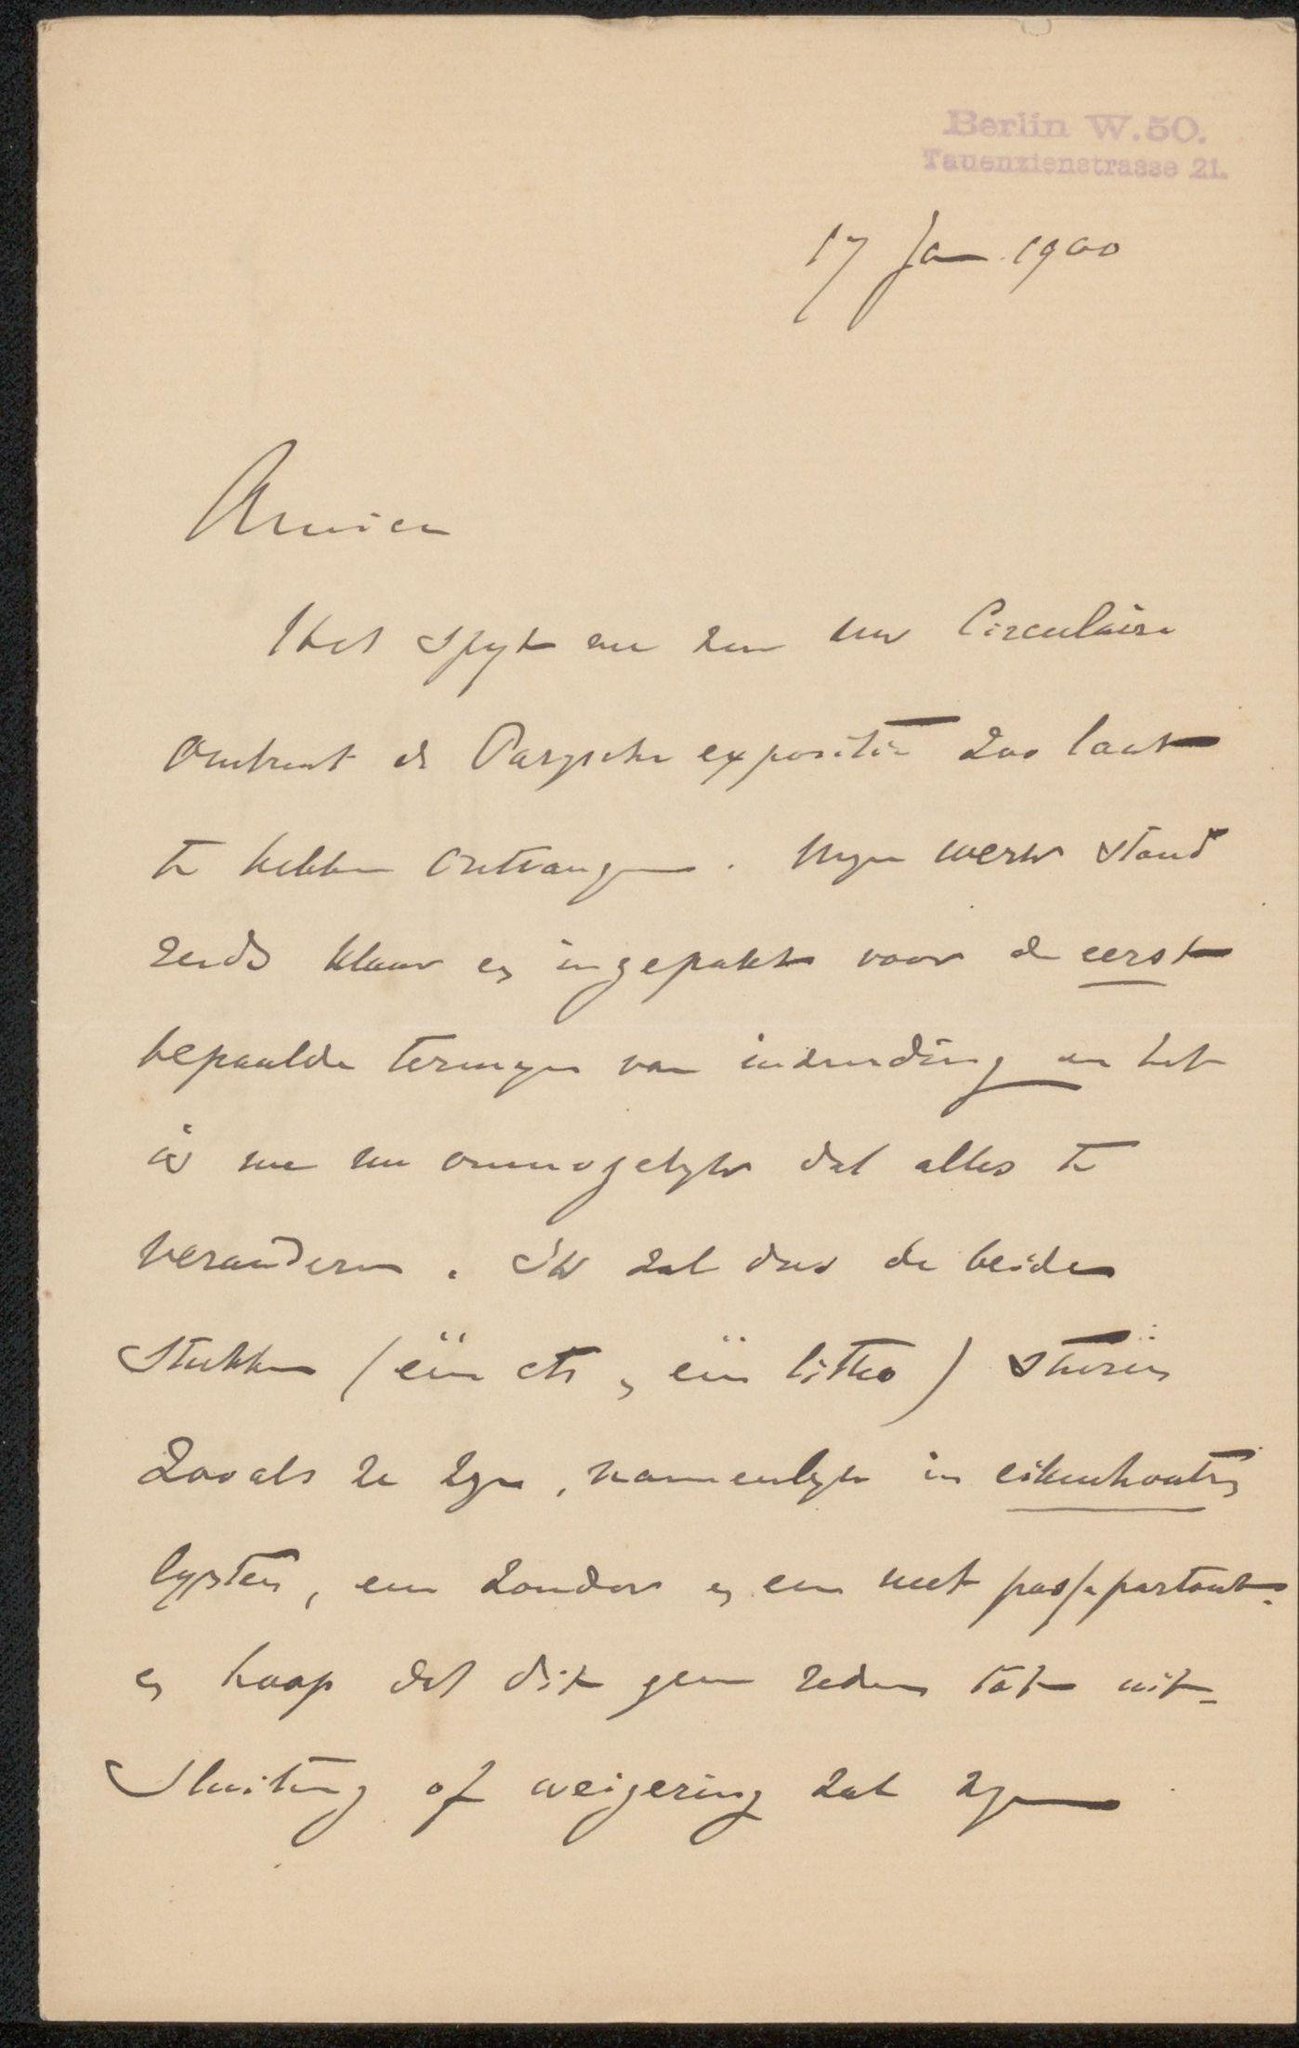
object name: letter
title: Brief aan Philip Zilcken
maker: carel nicolaas storm van s-gravesande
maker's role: draughtsman, print maker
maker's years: 1841-1924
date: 1900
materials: ink, paper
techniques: pen, writing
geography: berlin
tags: painter, philip zilcken, the graphic arts, exhibition ~ art, printed matter, the hague, paris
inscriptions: collector's mark: ‘RPK’, watermark, address: ‘Berlin W.50/ Tauenzienstrasse 21.’